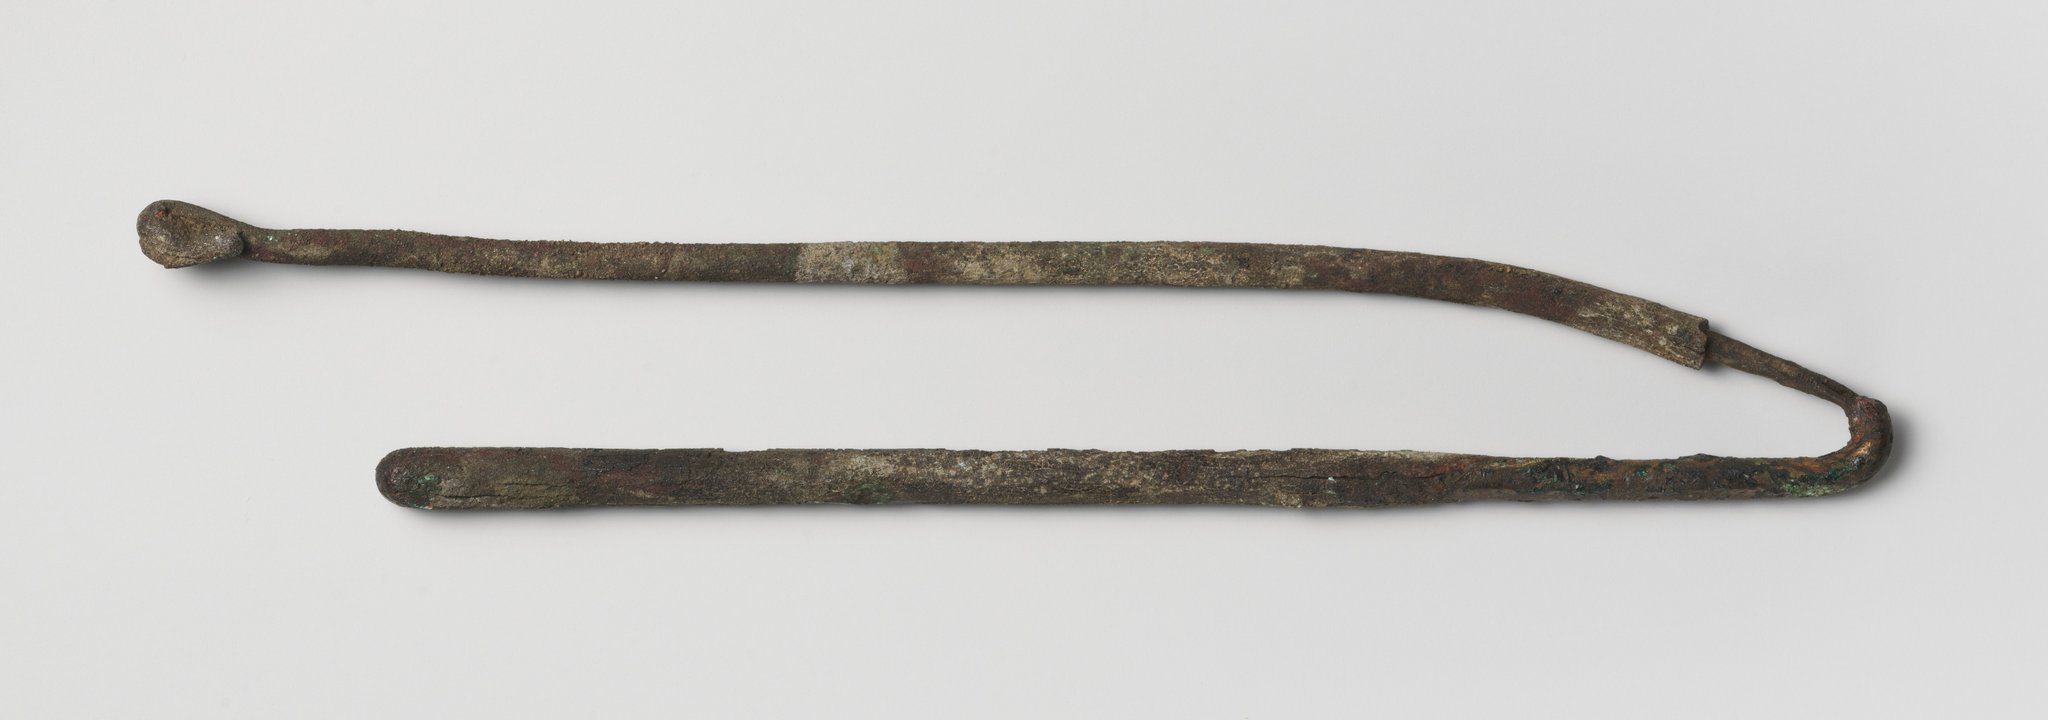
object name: wire, for jewelry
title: Bent piece of wire/Needle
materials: copper alloy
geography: egypt